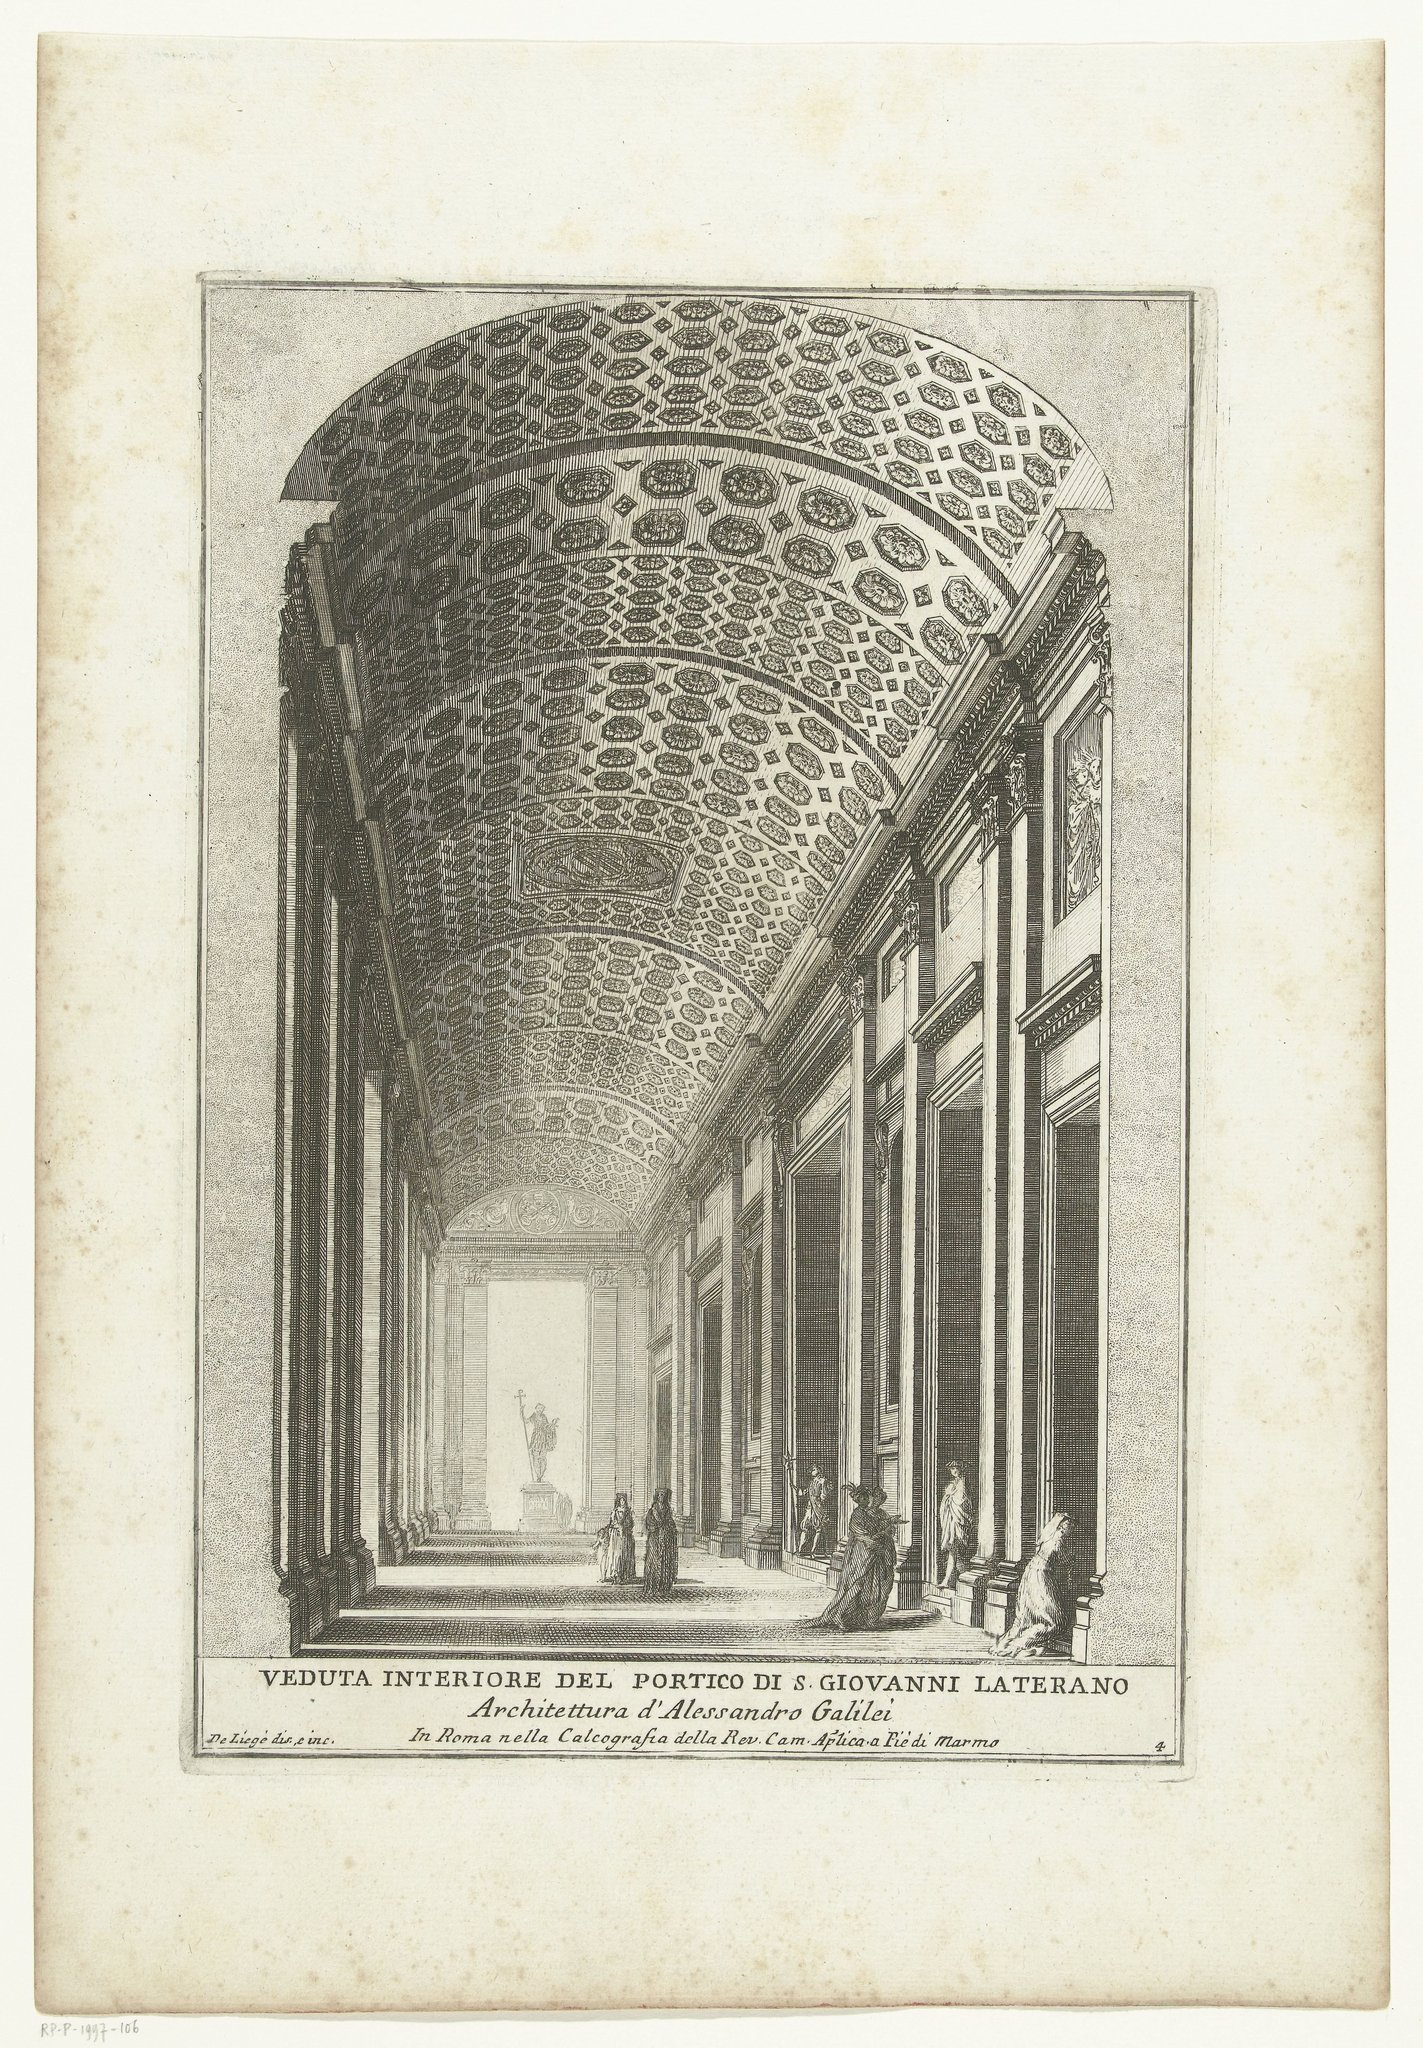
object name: print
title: Veduta Interiore del Portico di S. Giovanni Laterano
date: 1700-1760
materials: paper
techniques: engraving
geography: italy